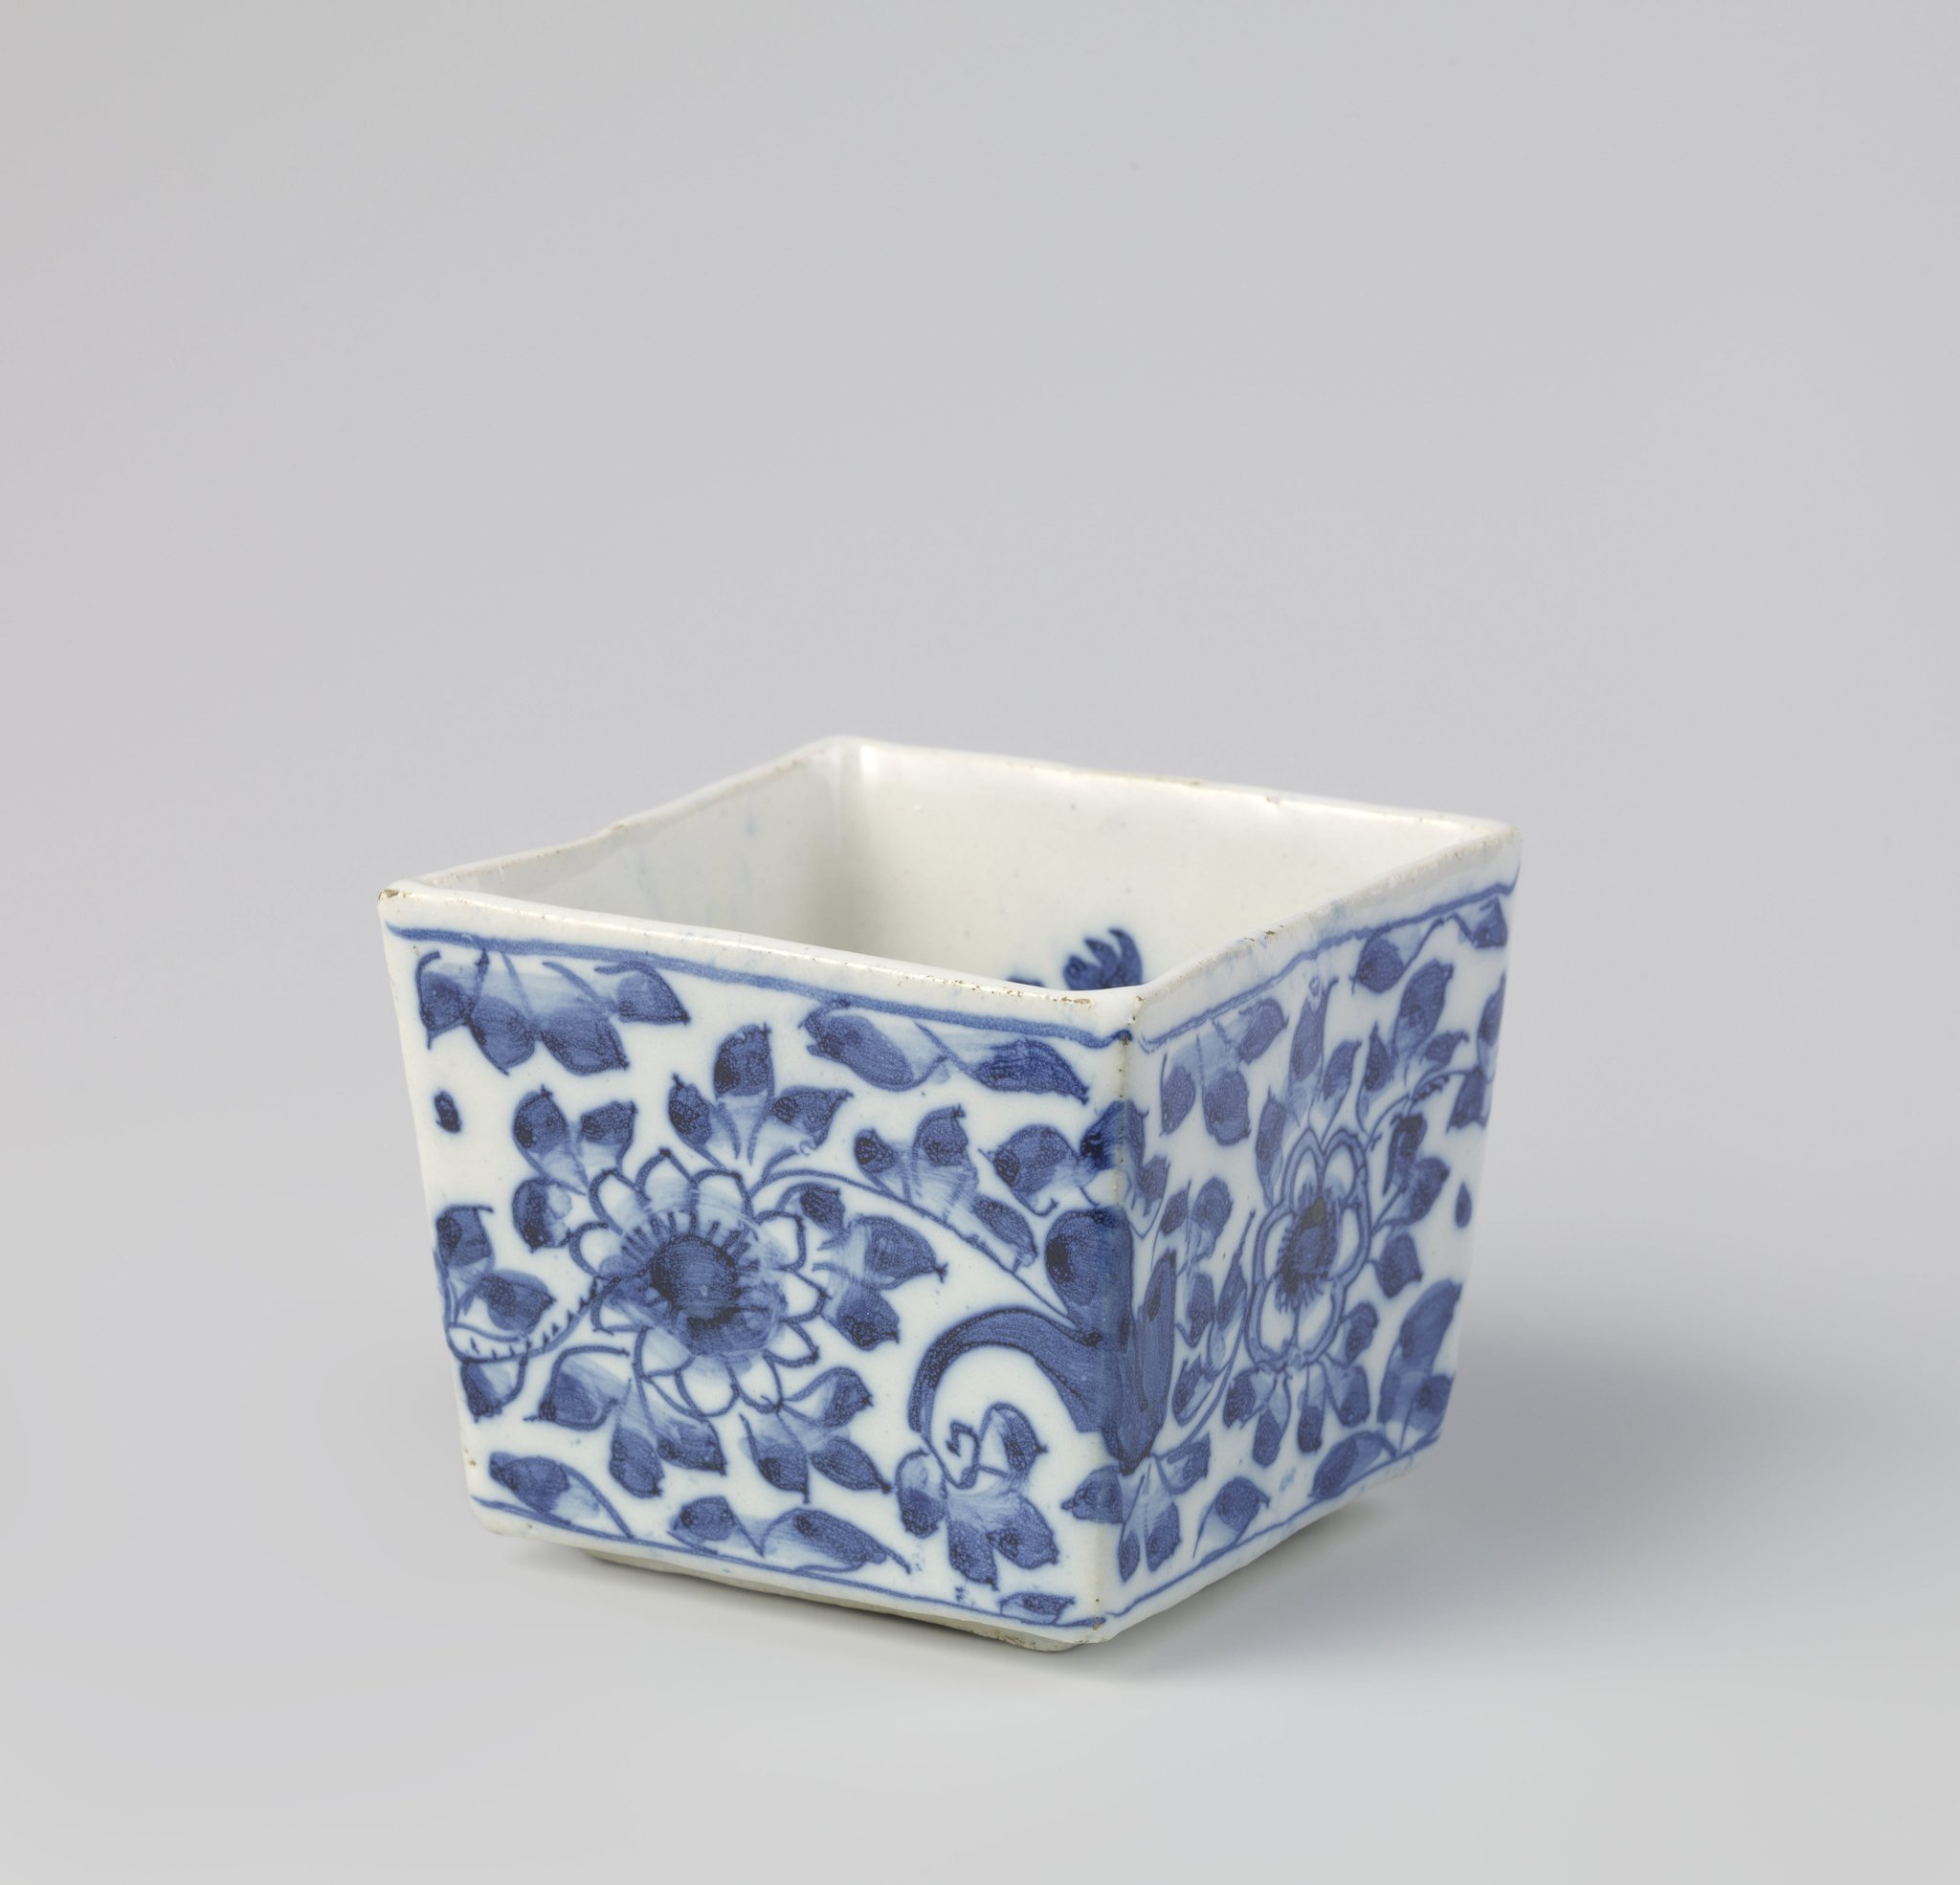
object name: bowl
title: Mukozuke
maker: Anonymous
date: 1670-1690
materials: earthenware, glaze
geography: delft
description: Vierkante kom van aardewerk met tinglazuur. Aan de buitenkant gedecoreerd met bloem-, vogel- en insectmotieven. Aan de onder en bovenkant afgesloten door een blauwe streep. Aan de binnenkant op elk van de zijden een klein plantmotief.